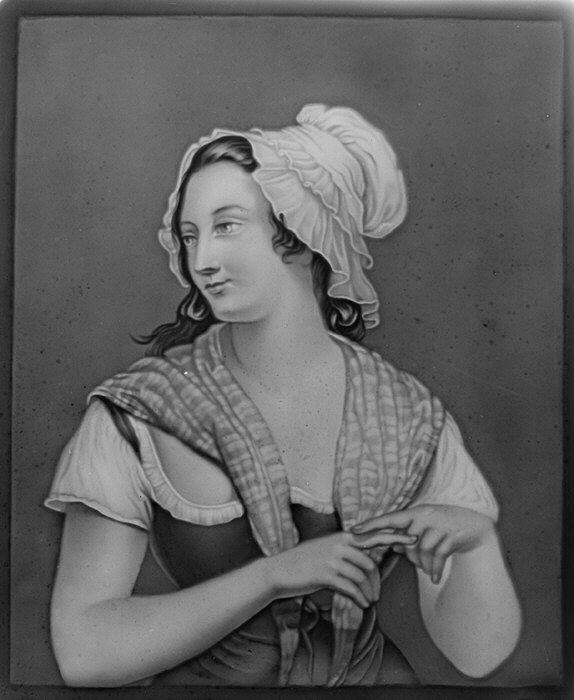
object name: lithophane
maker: royal porcelain manufactory, berlin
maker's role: manufactory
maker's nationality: german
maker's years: 1763-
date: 1834-1866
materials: porcelain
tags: portraits,women